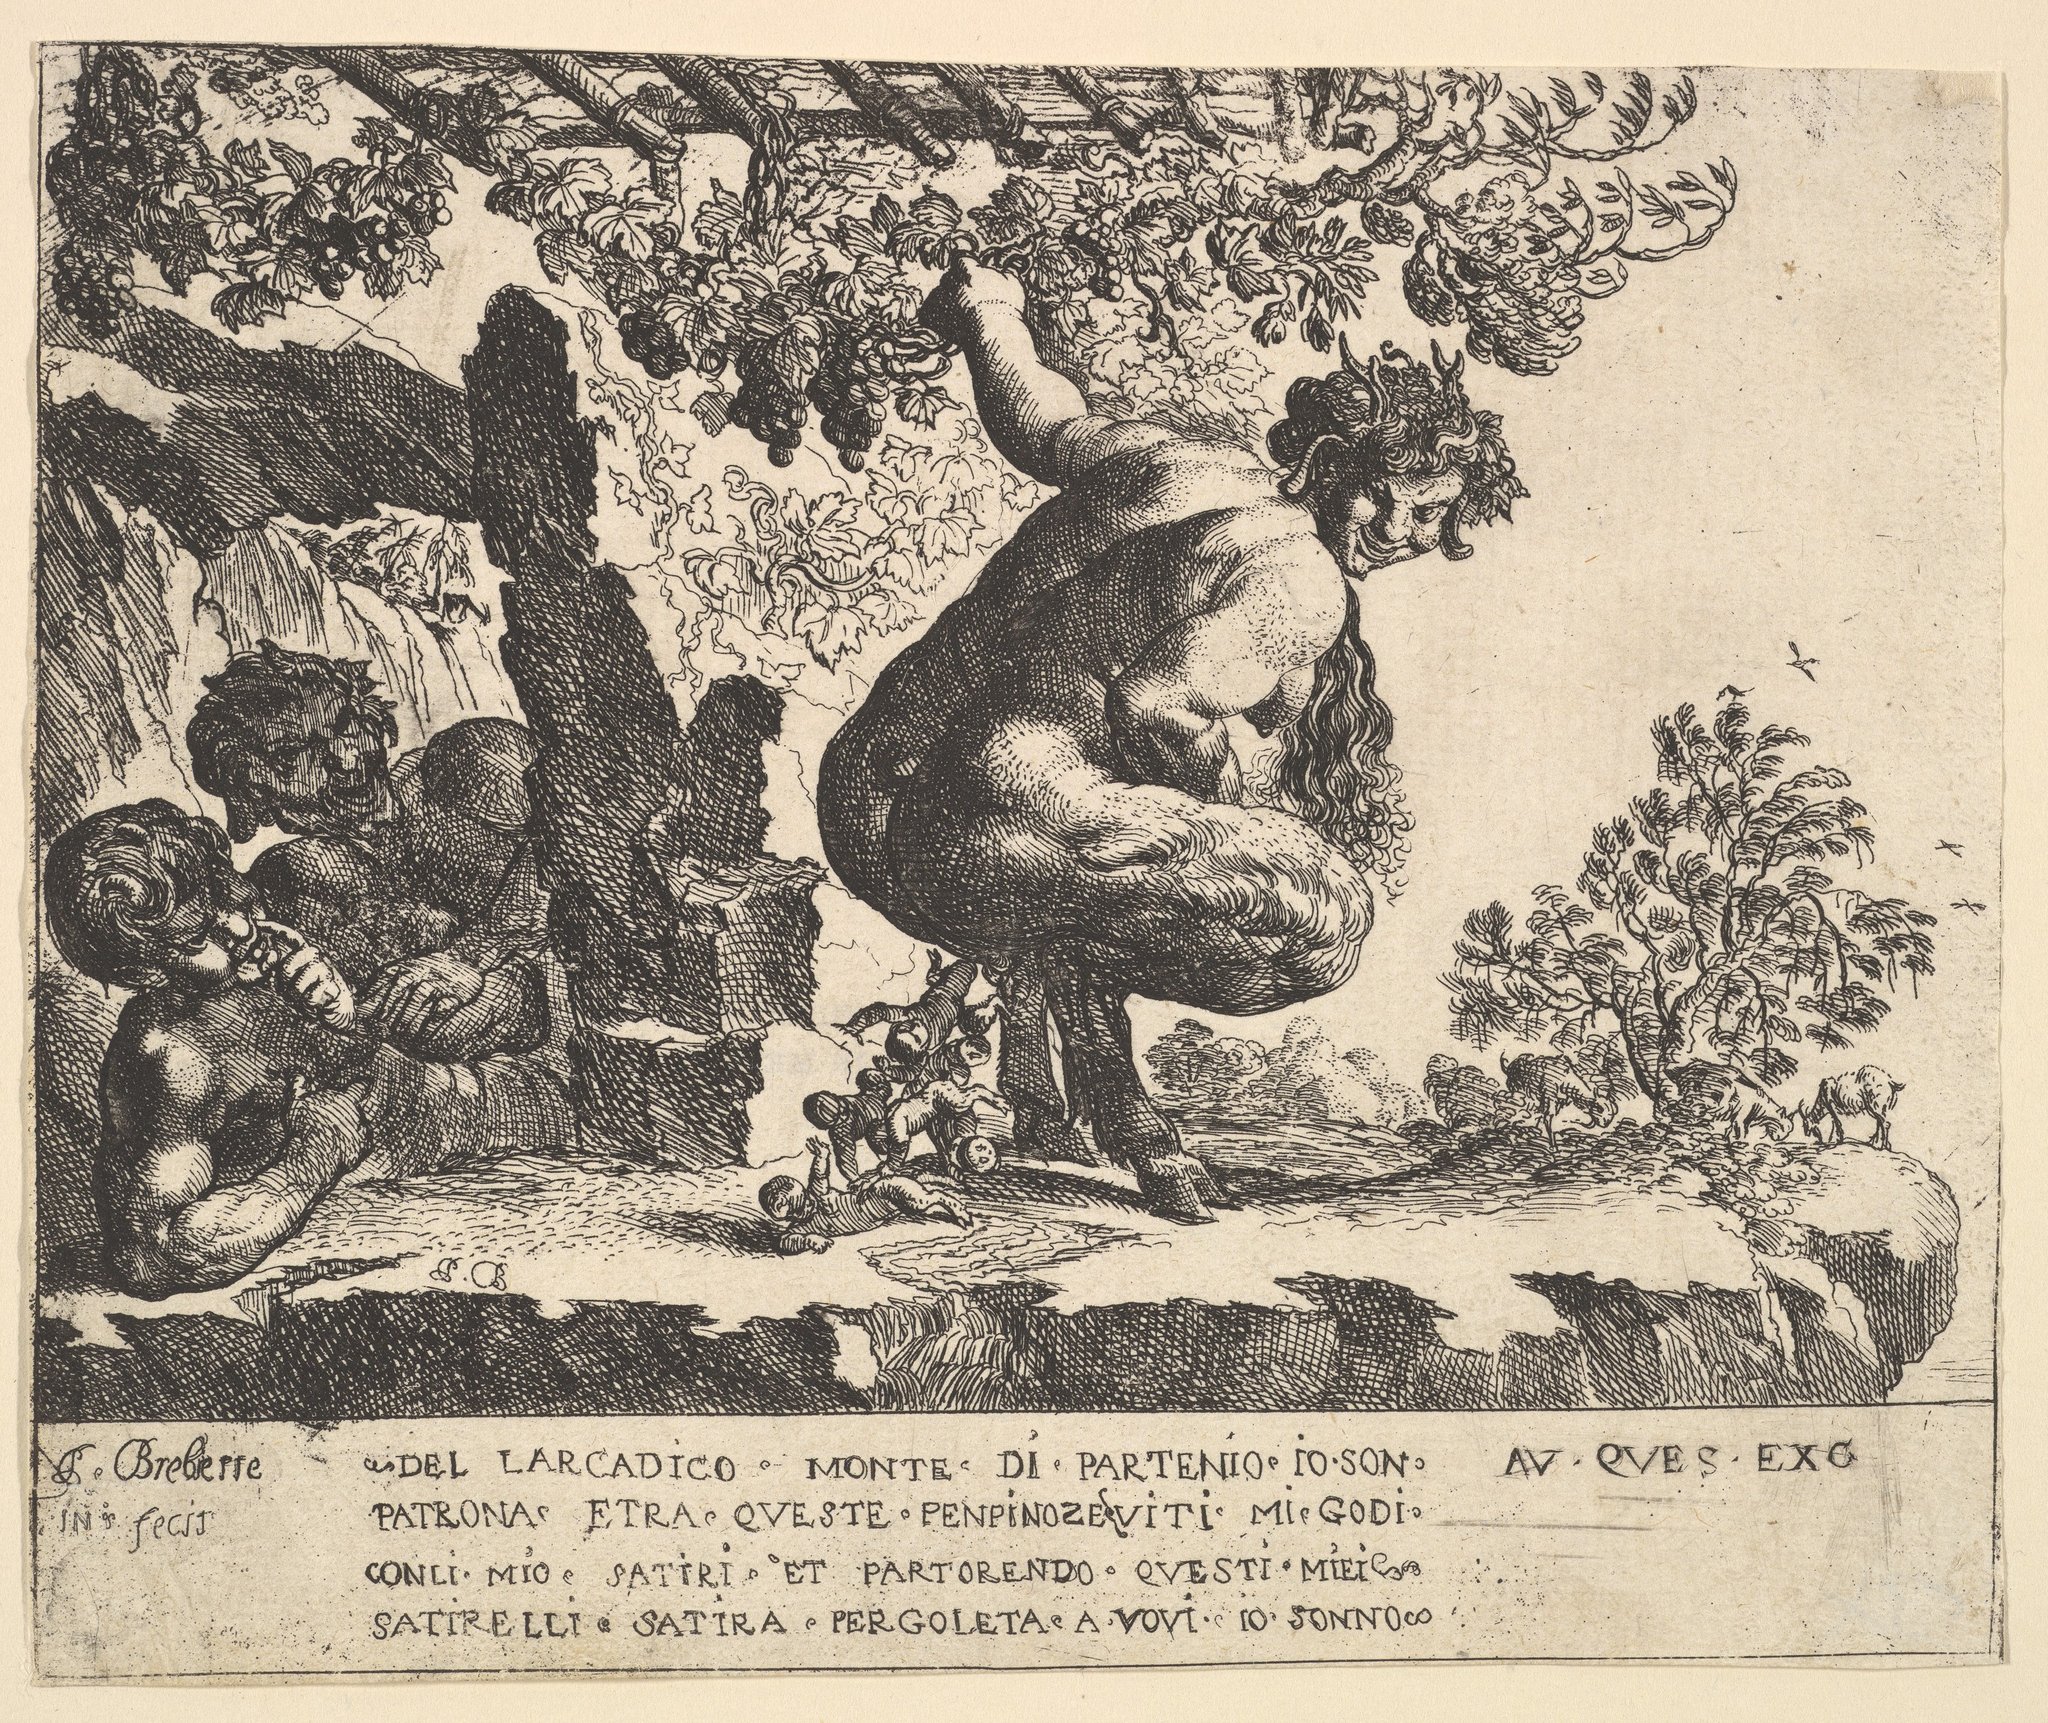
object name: print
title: Birth of the Satyrs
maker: pierre brebiette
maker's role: artist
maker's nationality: french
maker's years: 1598-1642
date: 1610-1642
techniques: etching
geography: france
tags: men,male nudes,satyrs,birth